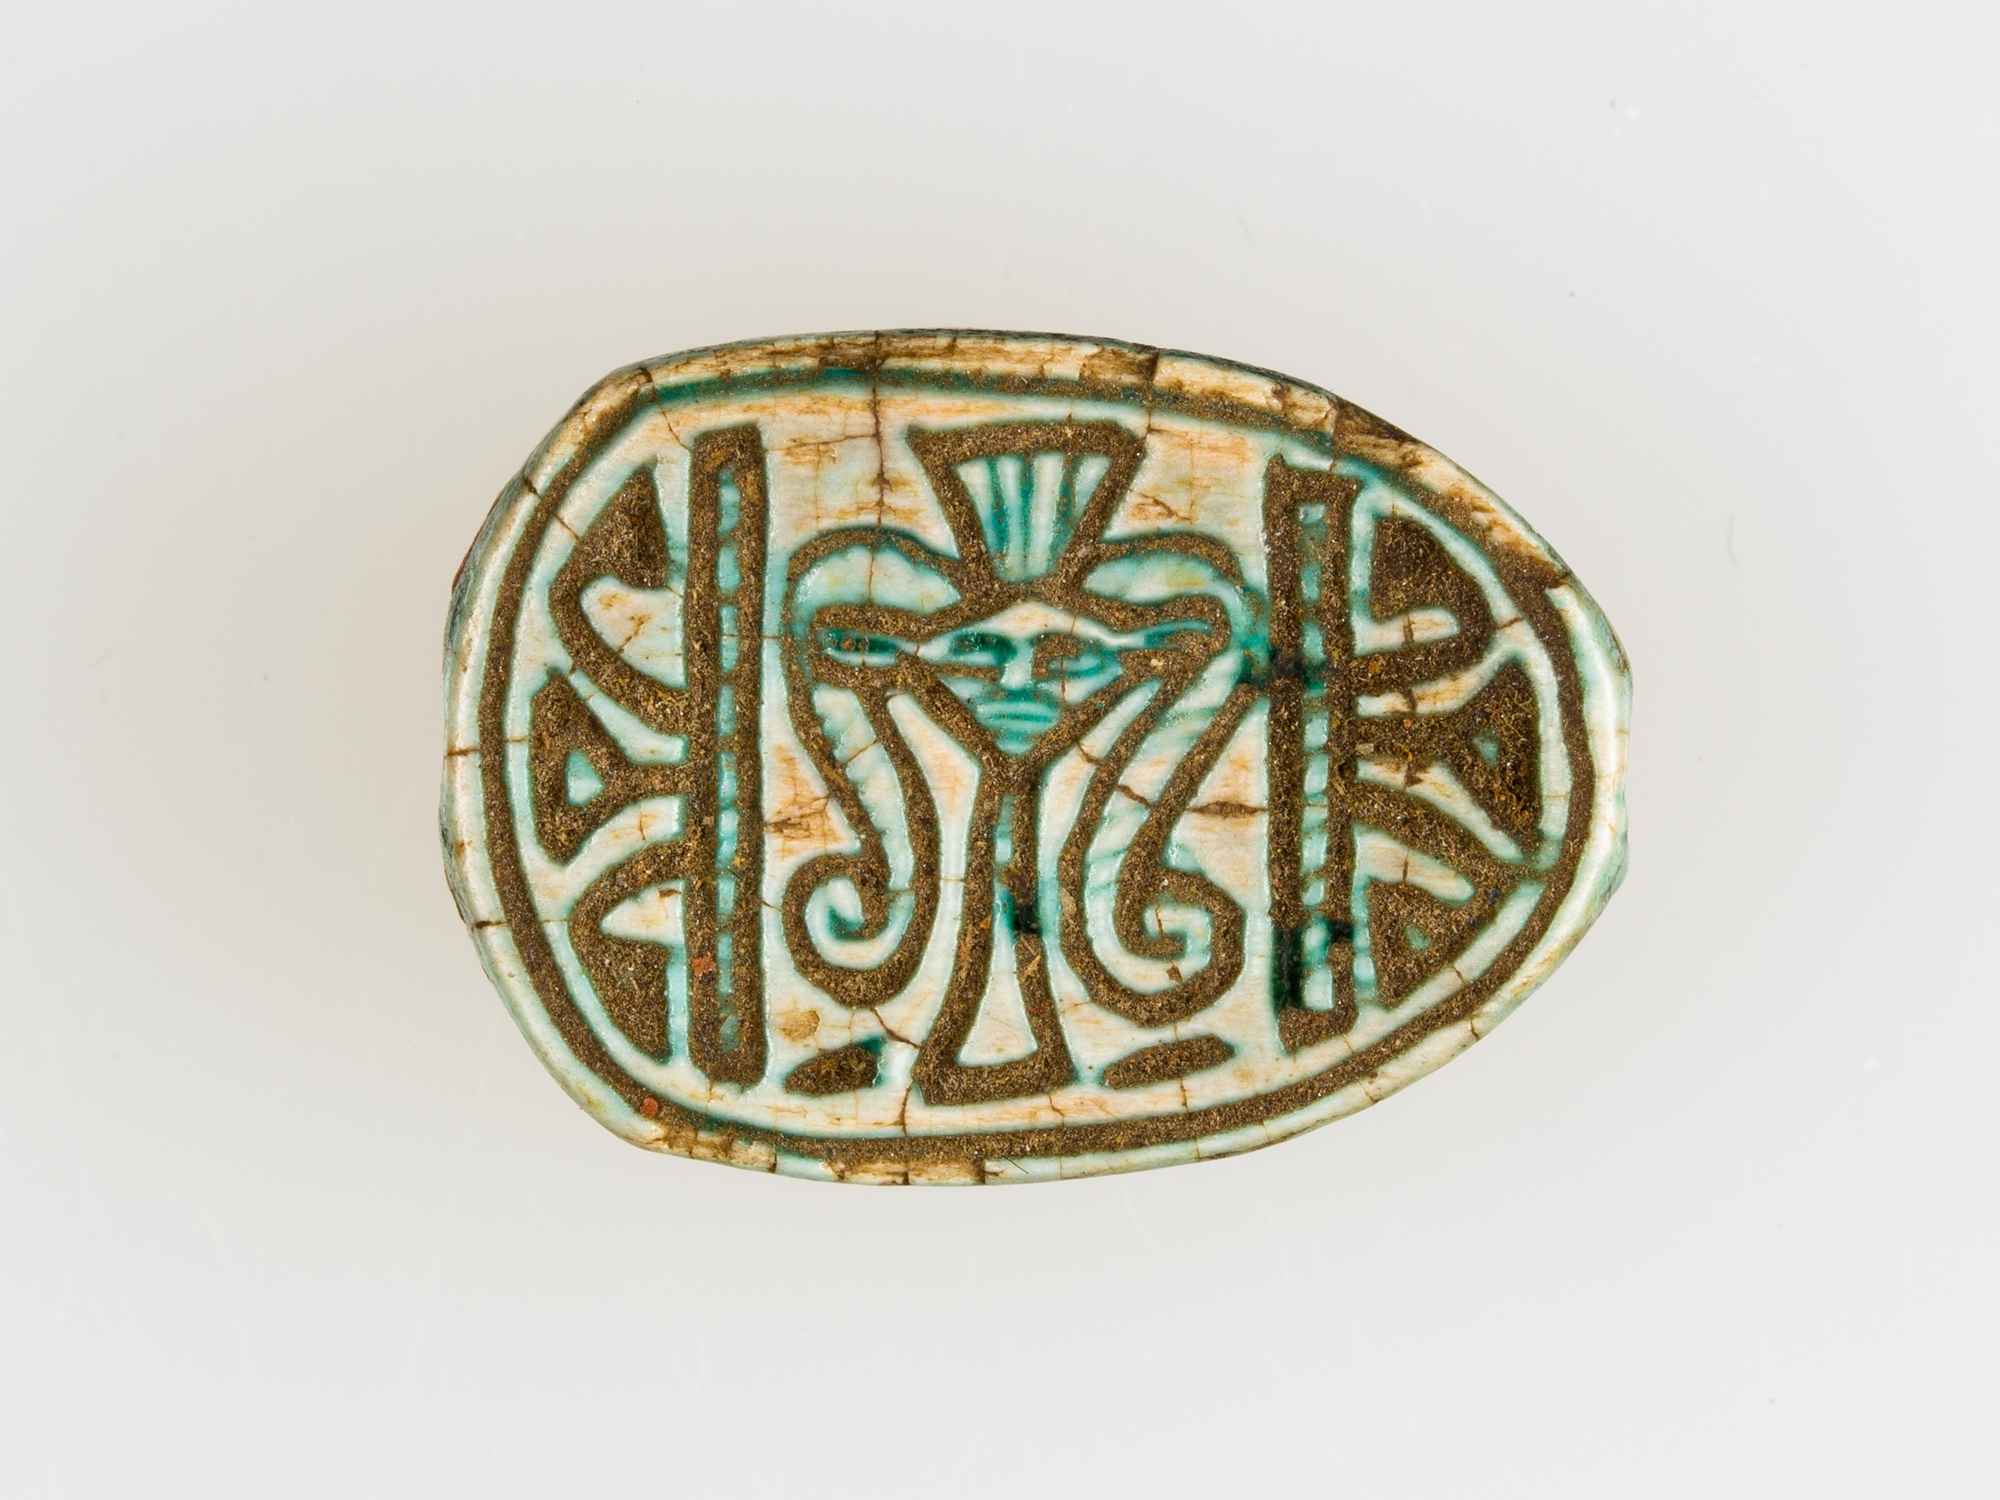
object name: scarab, hathor emblem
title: Scarab with Hathor emblem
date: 1550-1425 BCE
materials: faience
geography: egypt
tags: hathor,scarabs